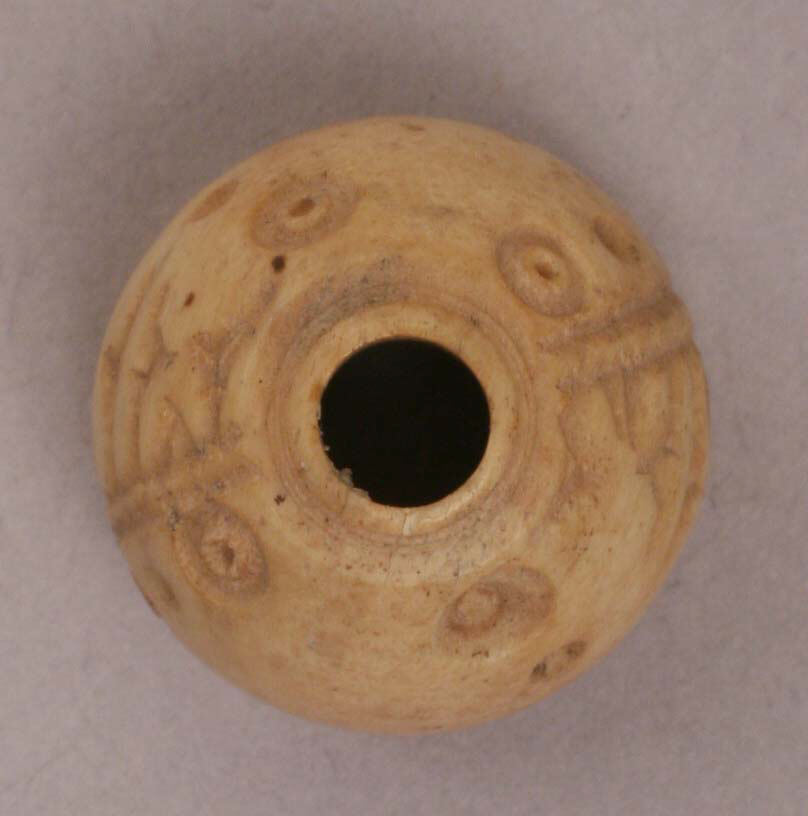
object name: button or bead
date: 801-1000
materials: bone, paint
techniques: incising, inlay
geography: iran